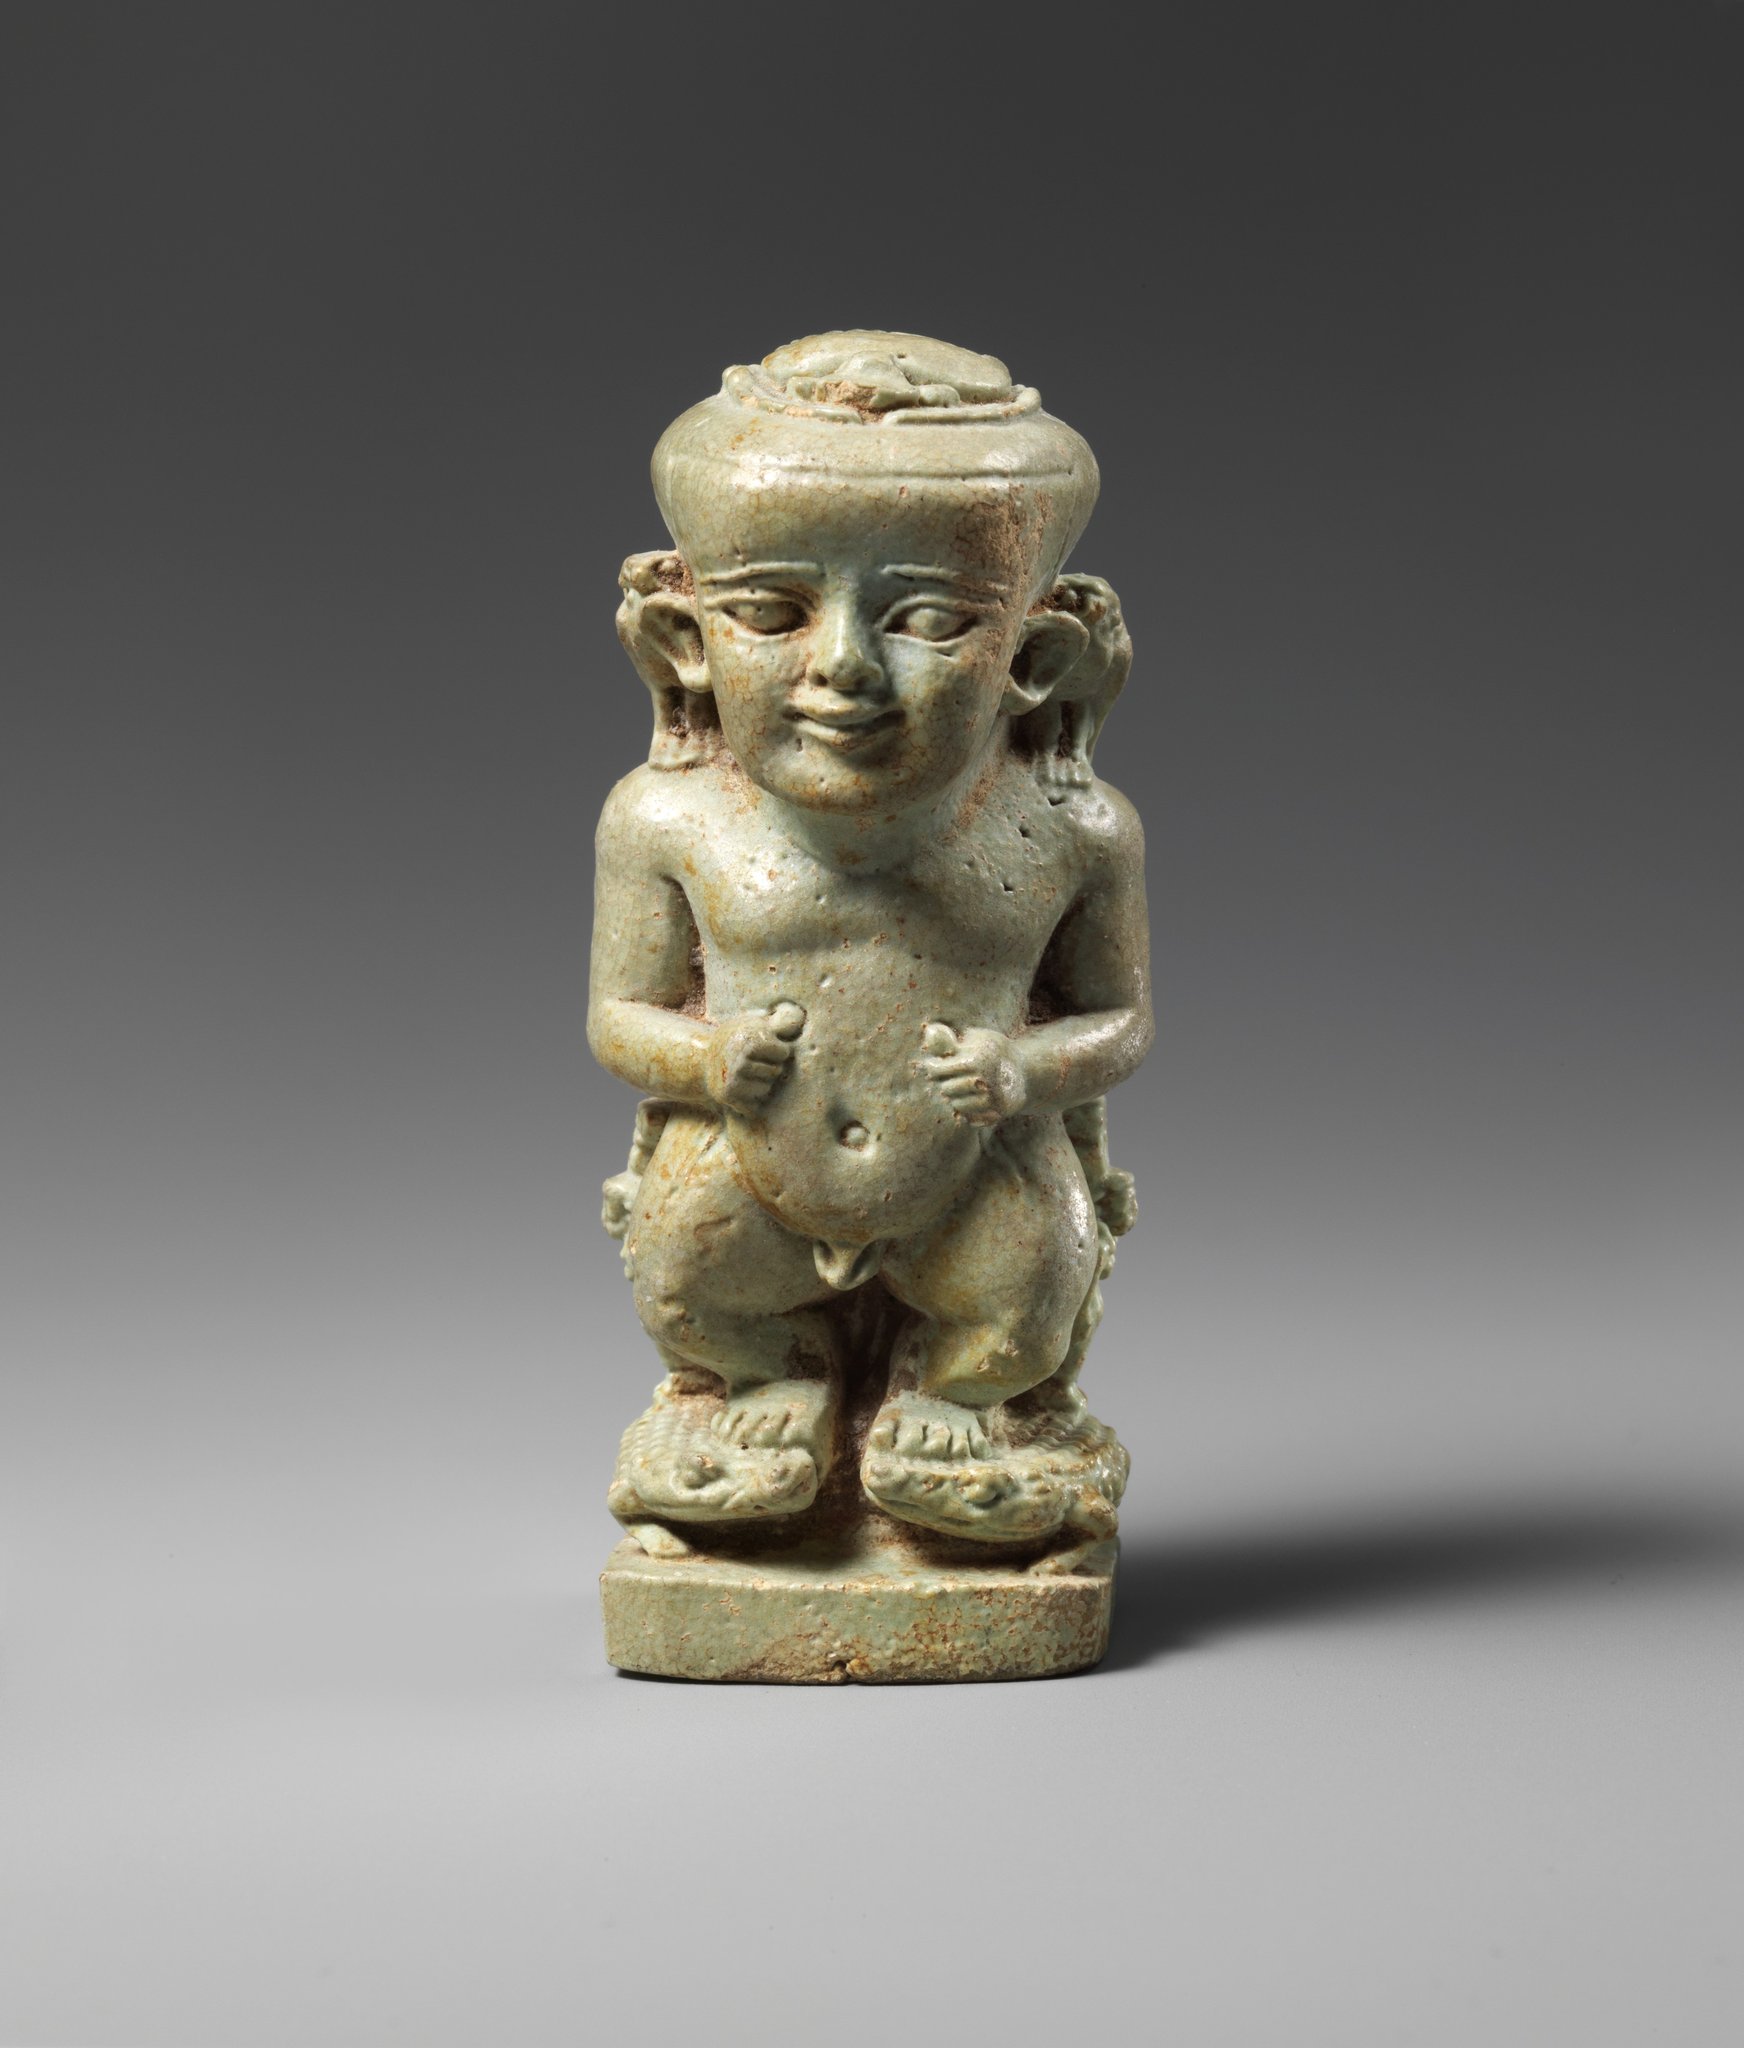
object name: amulet, pataikos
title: Amulet of the God Pataikos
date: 664-332 BCE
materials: faience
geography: egypt